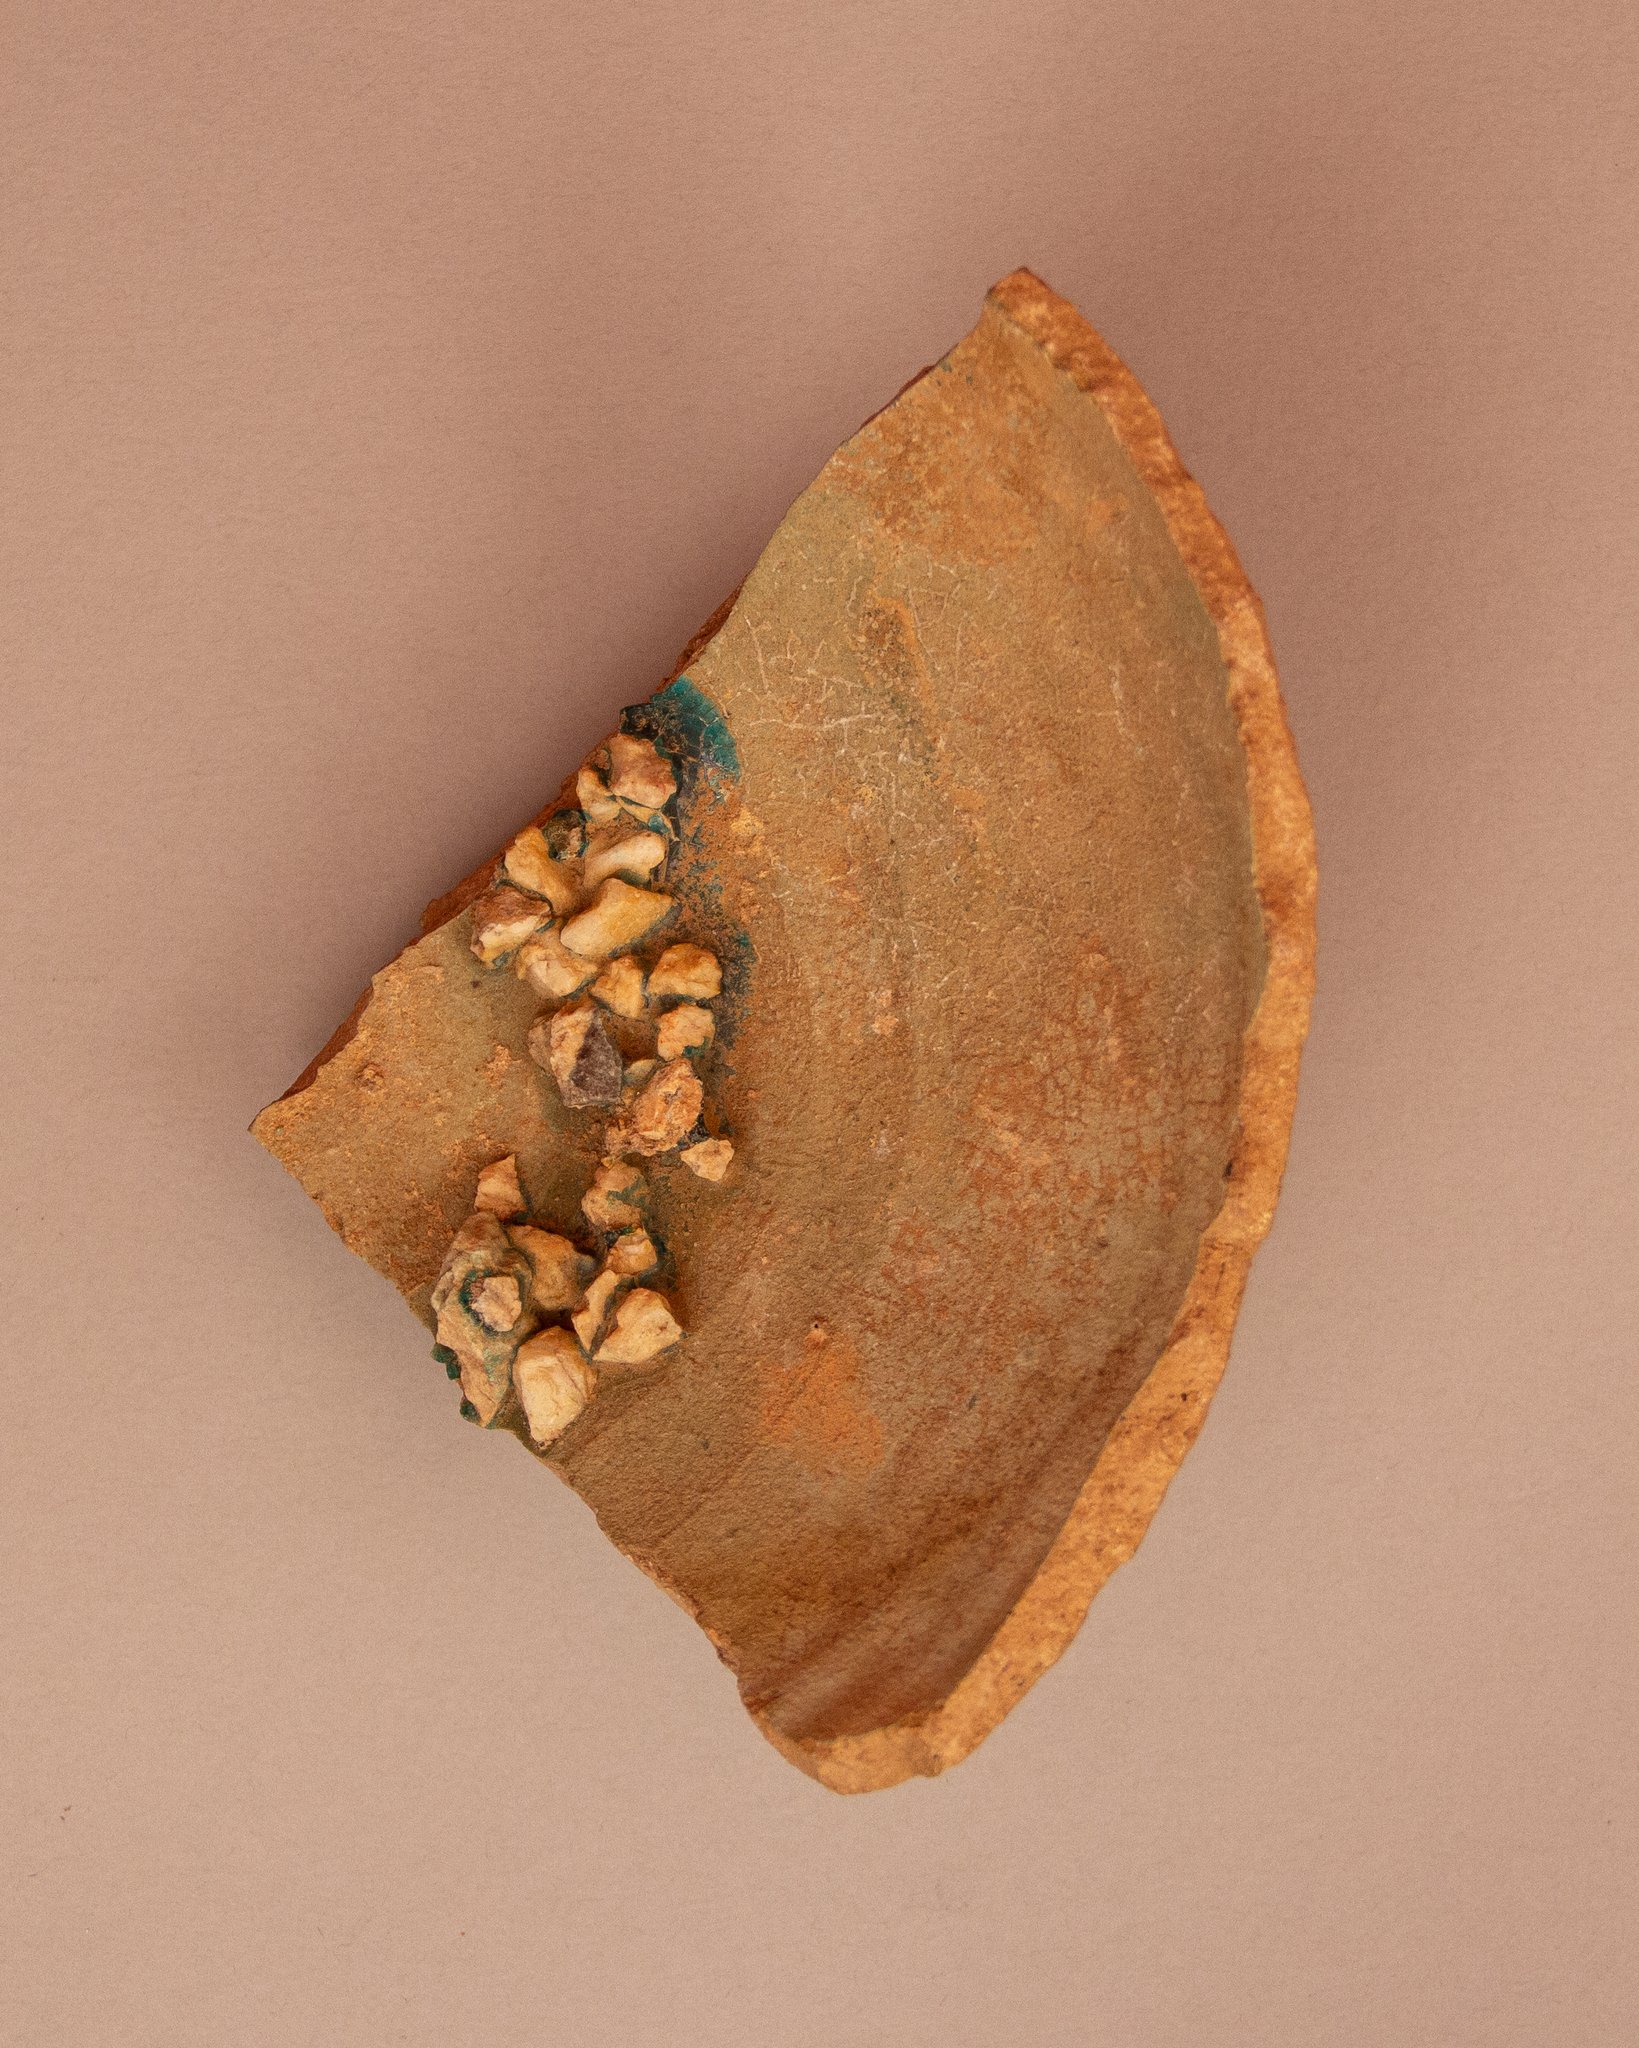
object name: fragment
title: Ceramic Fragment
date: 1001-1200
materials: earthenware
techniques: glazing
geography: iran